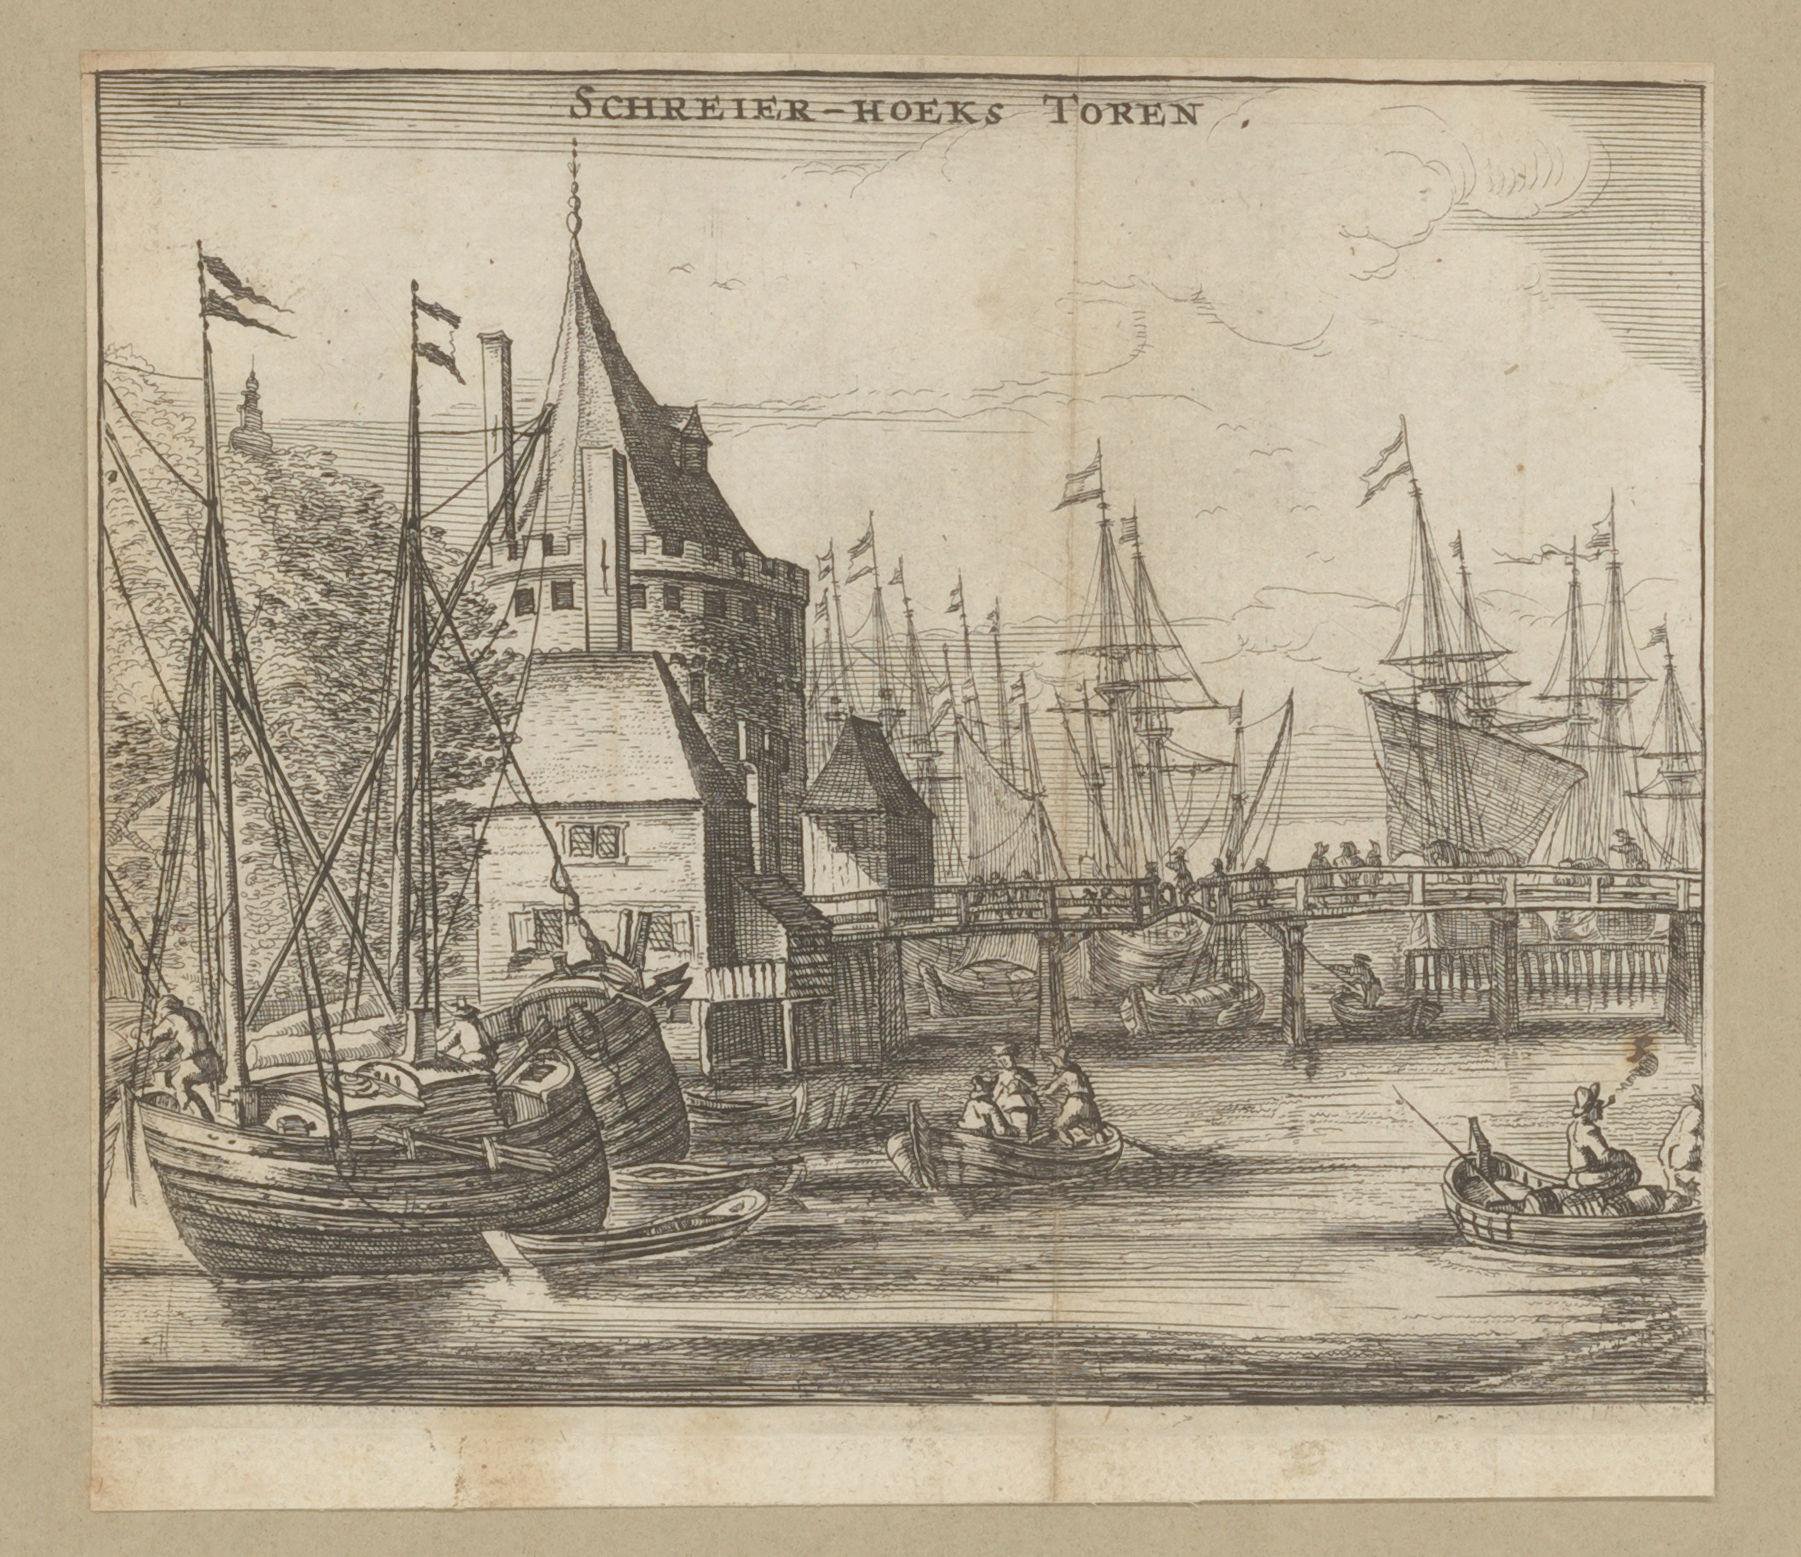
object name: print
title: Gezicht op de Schreierstoren te Amsterdam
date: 1664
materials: paper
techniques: engraving, etching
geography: amsterdam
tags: bridge in city across river, canal, etc. (+ city(-scape) with figures, staffage), sailing-ship, sailing-boat, towers ~ fortified city, rowing-boat, canoe, etc.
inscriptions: collector's mark: Lugt 1641b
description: Huidige staat van prent ook gebruikt in: Fockens, Melchior. Beschrijvingh Der wijdt-vermaarde Koop-stadt Amstelredam (…). 3de druk. Amsterdam: Marcus Willemsz. Doornick, 1664. En in: Zesen, Philipp von. Beschreibung der Stadt Amsterdam (…). Amsterdam: Marcus Willemsz. Doornick, 1664. Tweede bekende staat (met toevoeging Franse titel) ook gebruikt in: Domselaer, Tobias en Isaac Commelin. Beschryvinge van Amsterdam (…). 6 dln. Amsterdam: Marcus Willemsz. Doornick, 1665, dl. 4, p. 263. Derde bekende staat (rechtsboven genummerd: 63) ook gebruikt in verschillende latere zeventiende- en achttiende-eeuwse publicaties.